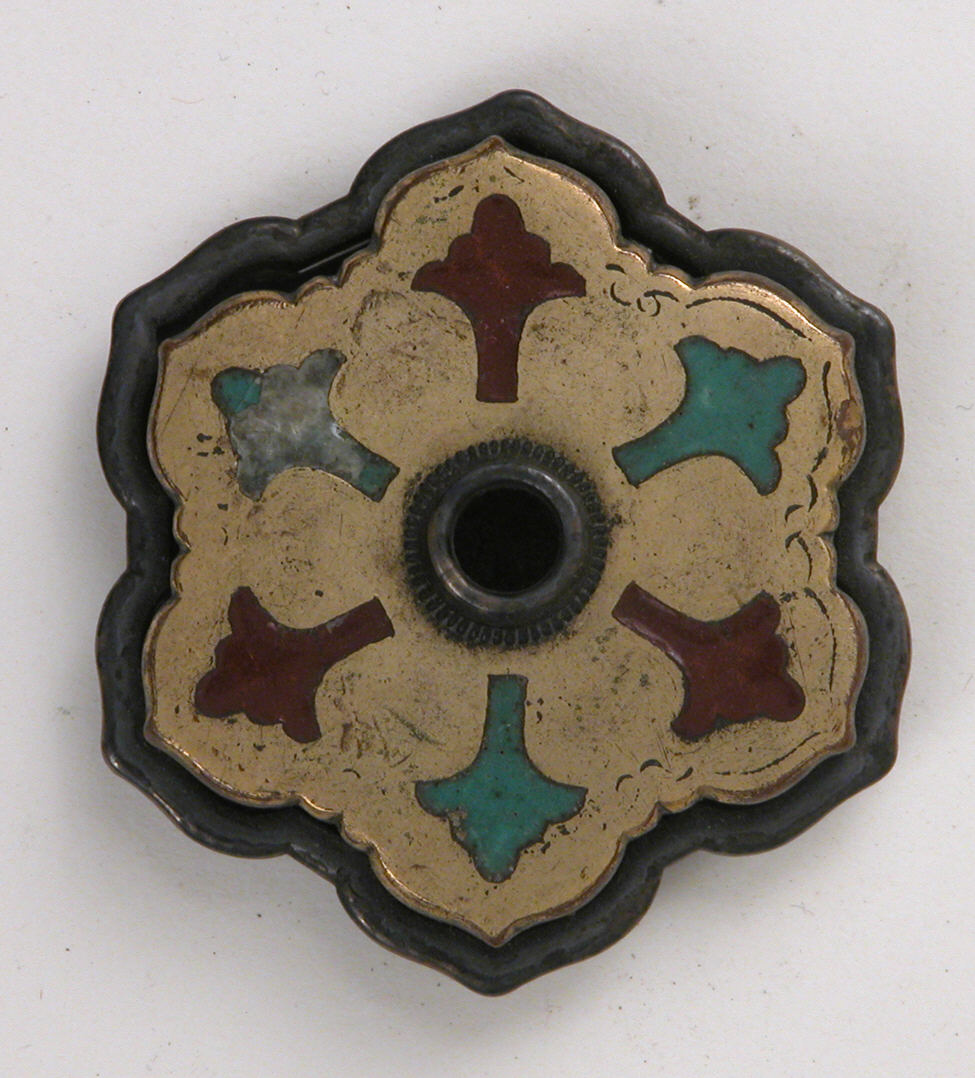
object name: jar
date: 1701-1800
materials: enamel, silver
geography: india